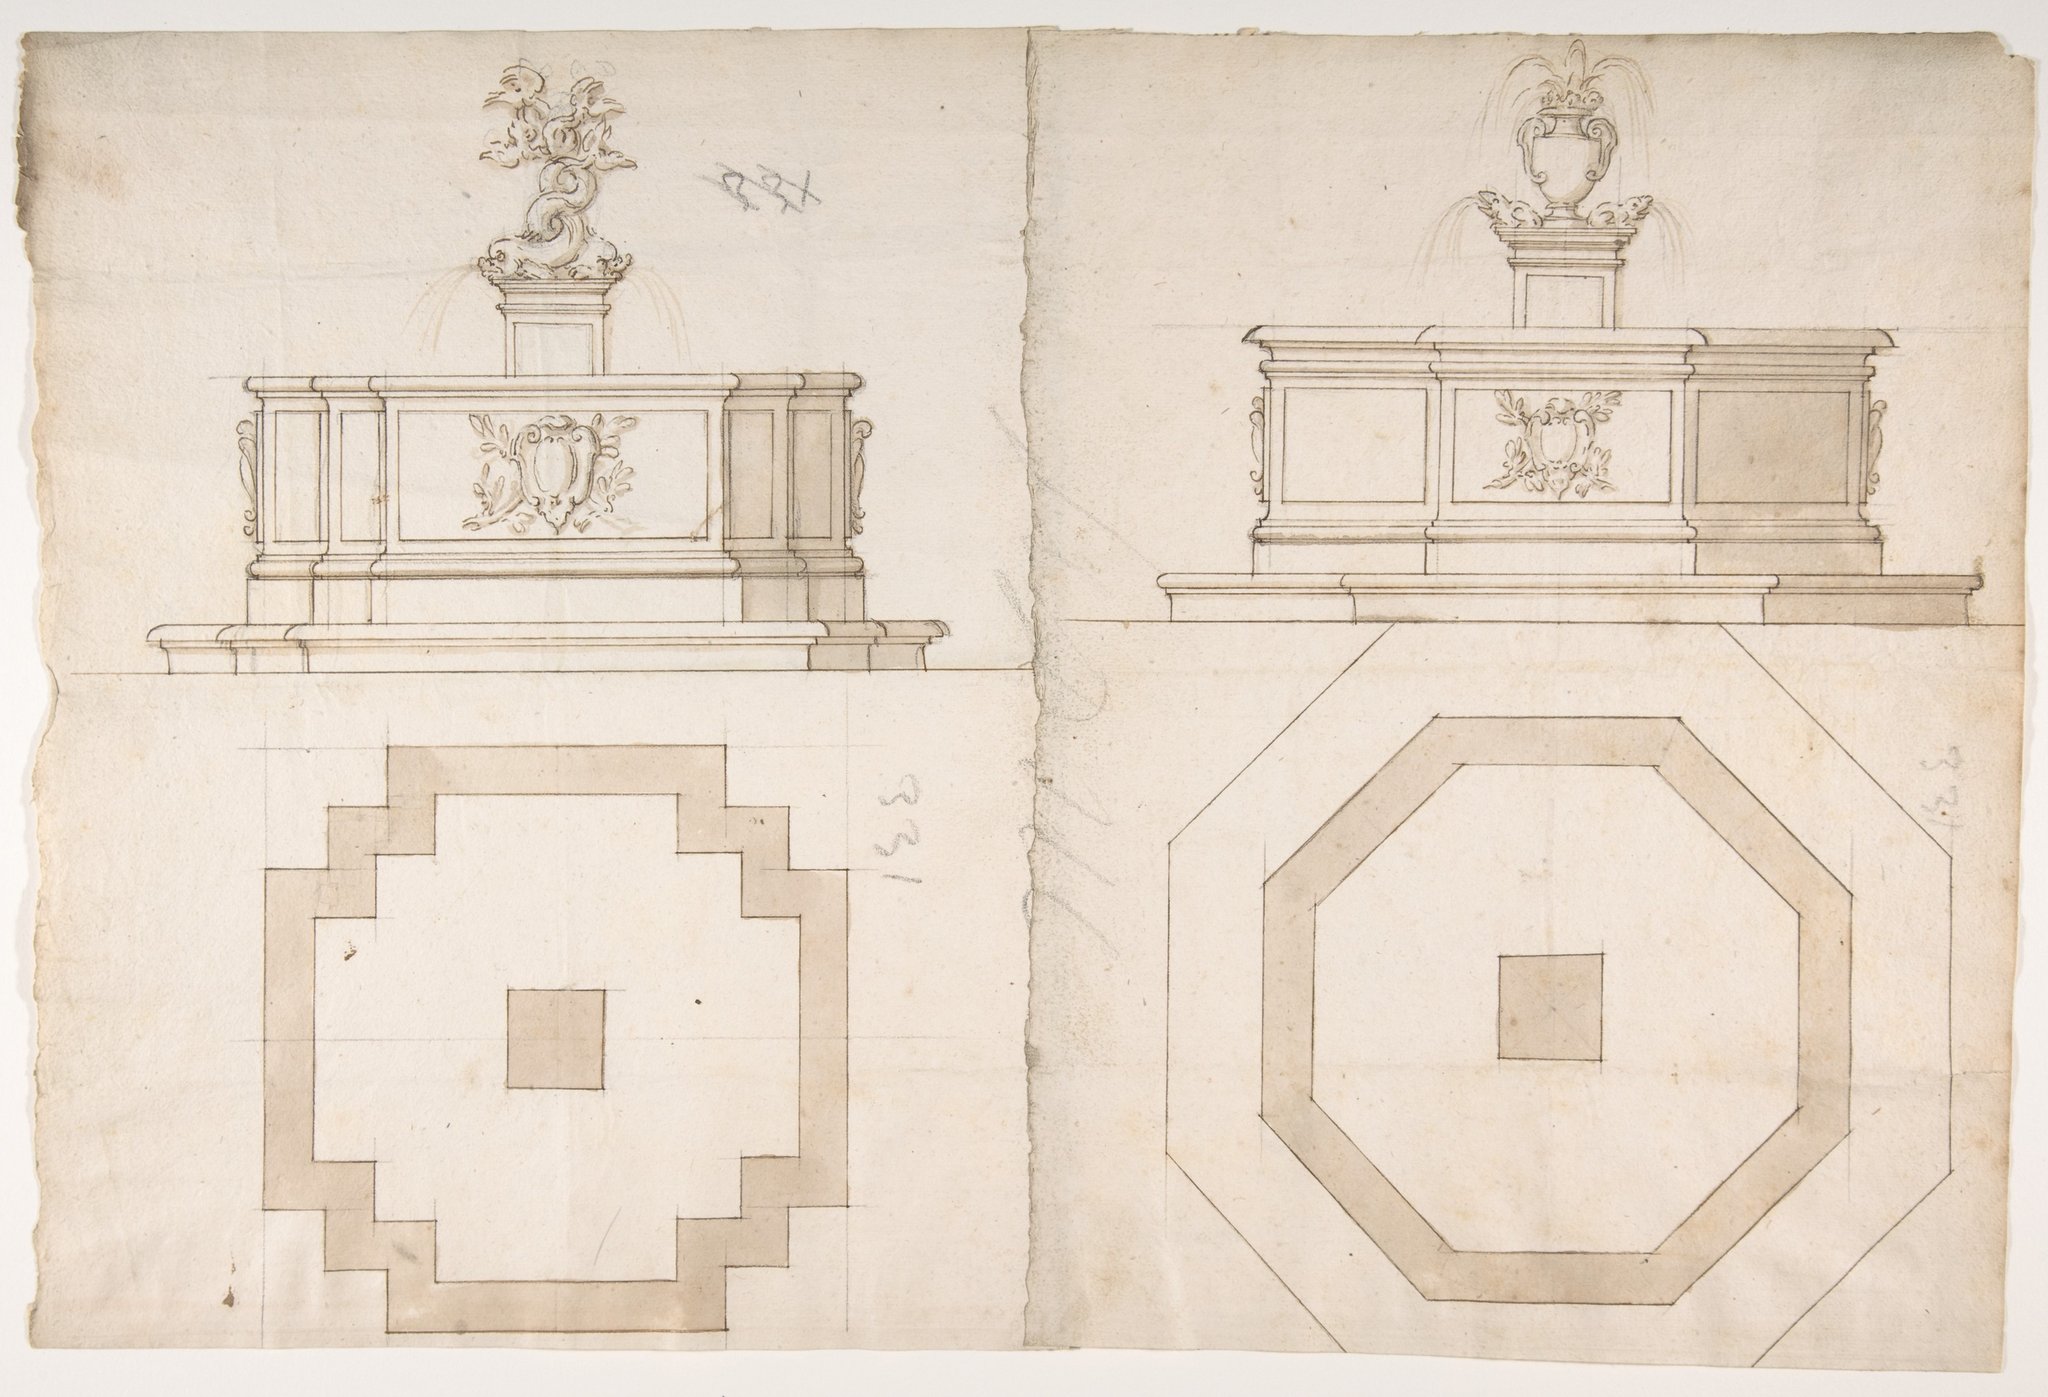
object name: drawing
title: Two Plans and Elevations for Fountains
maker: anonymous, french, 16th century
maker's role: artist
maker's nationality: french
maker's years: 1500-1600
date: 1501-1600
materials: chalk, ink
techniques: brush, pen, wash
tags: architecture,fountains